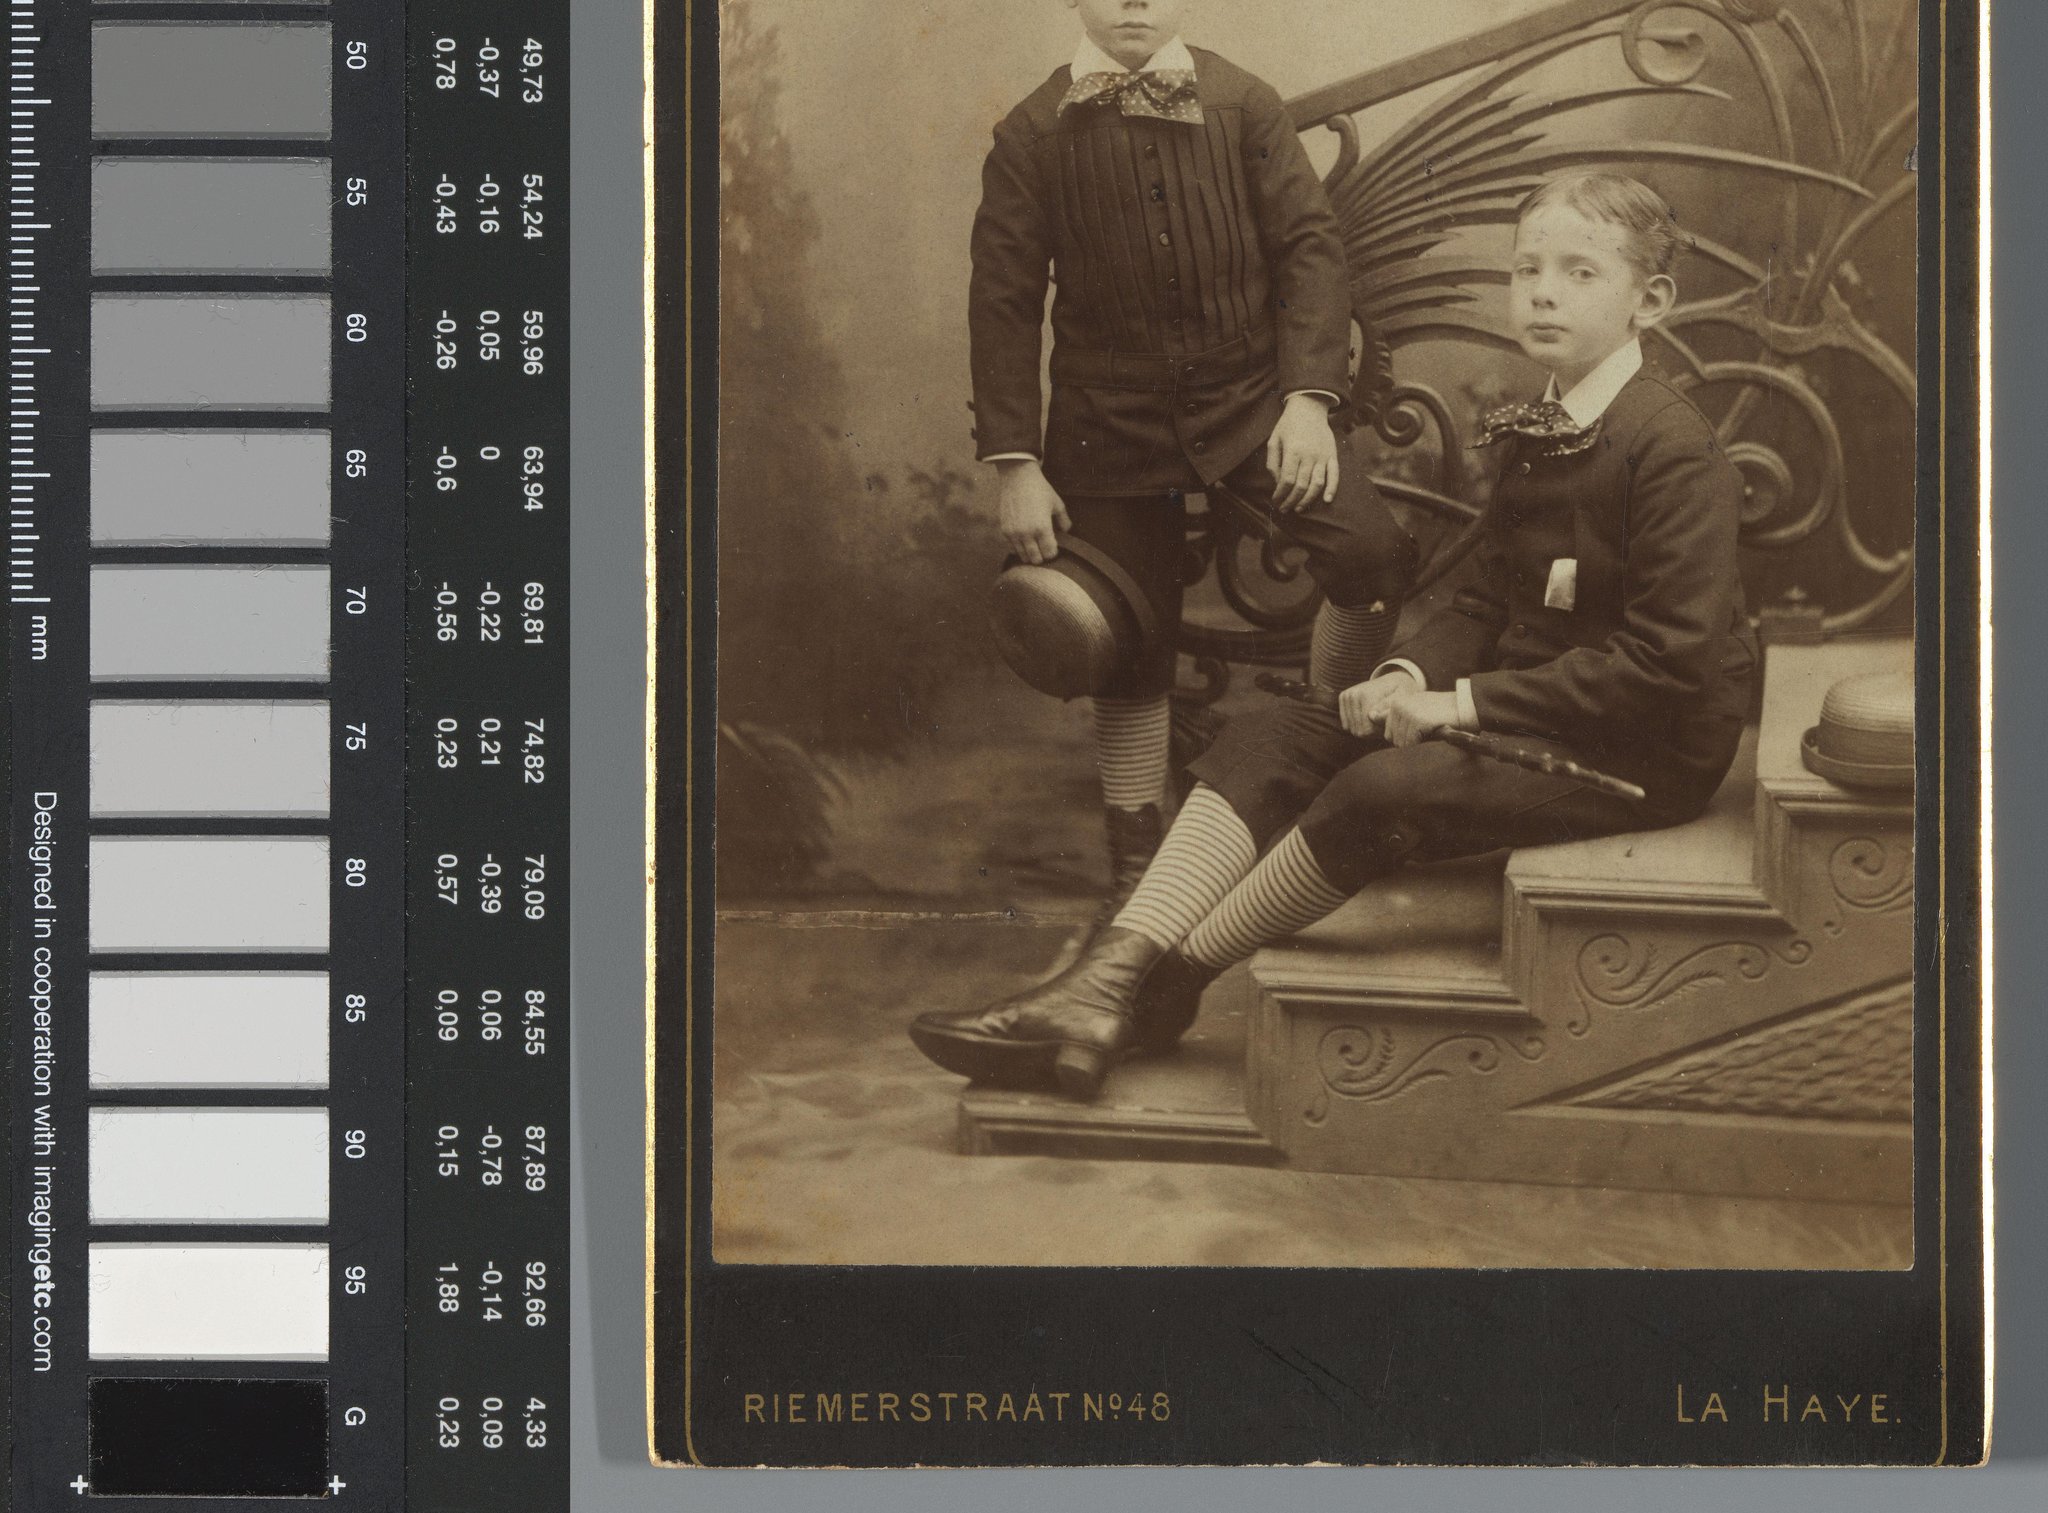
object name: cabinet photograph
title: Studioportret van twee jongens bij een trap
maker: adolphe zimmermans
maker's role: fotograaf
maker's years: 1858-1922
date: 1882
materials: cardboard, photographic support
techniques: albumen print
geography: the hague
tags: batavia, karel frederik van den berg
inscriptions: inscription: ‘ADOLPHE / RIEMERSTRAAT No. 48 LA HAYE.’, name: ‘Oom Karel & vader / ± 1882’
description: Studioportret van twee jongens bij een trap; Karel van den Berg zit op de trap, de andere jongen staat met een hoed in zijn hand.